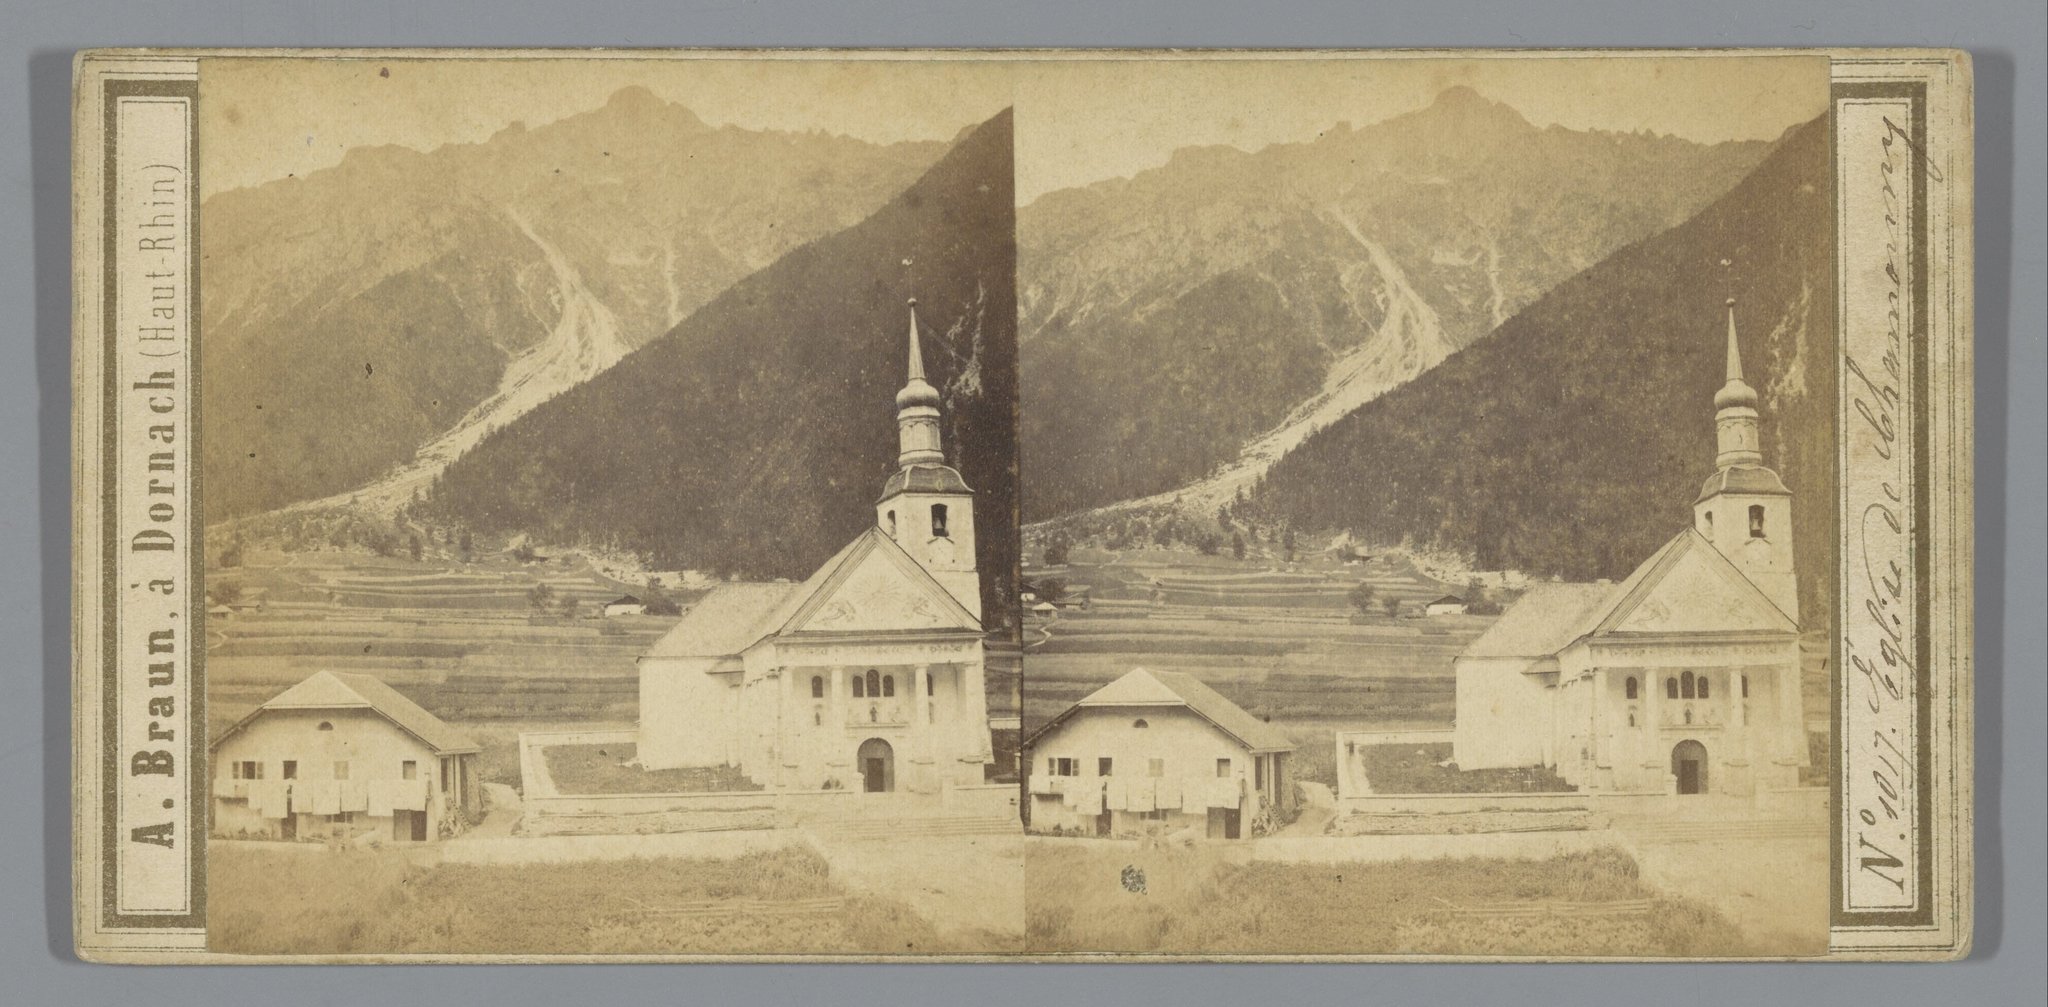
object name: stereograph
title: Église Saint-Michel in Chamonix, Frankrijk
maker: Anonymous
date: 1860-1864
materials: cardboard, paper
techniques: albumen print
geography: dornach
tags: roman catholic church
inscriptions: number: ‘No. 1017.’, inscription: ‘A L.’